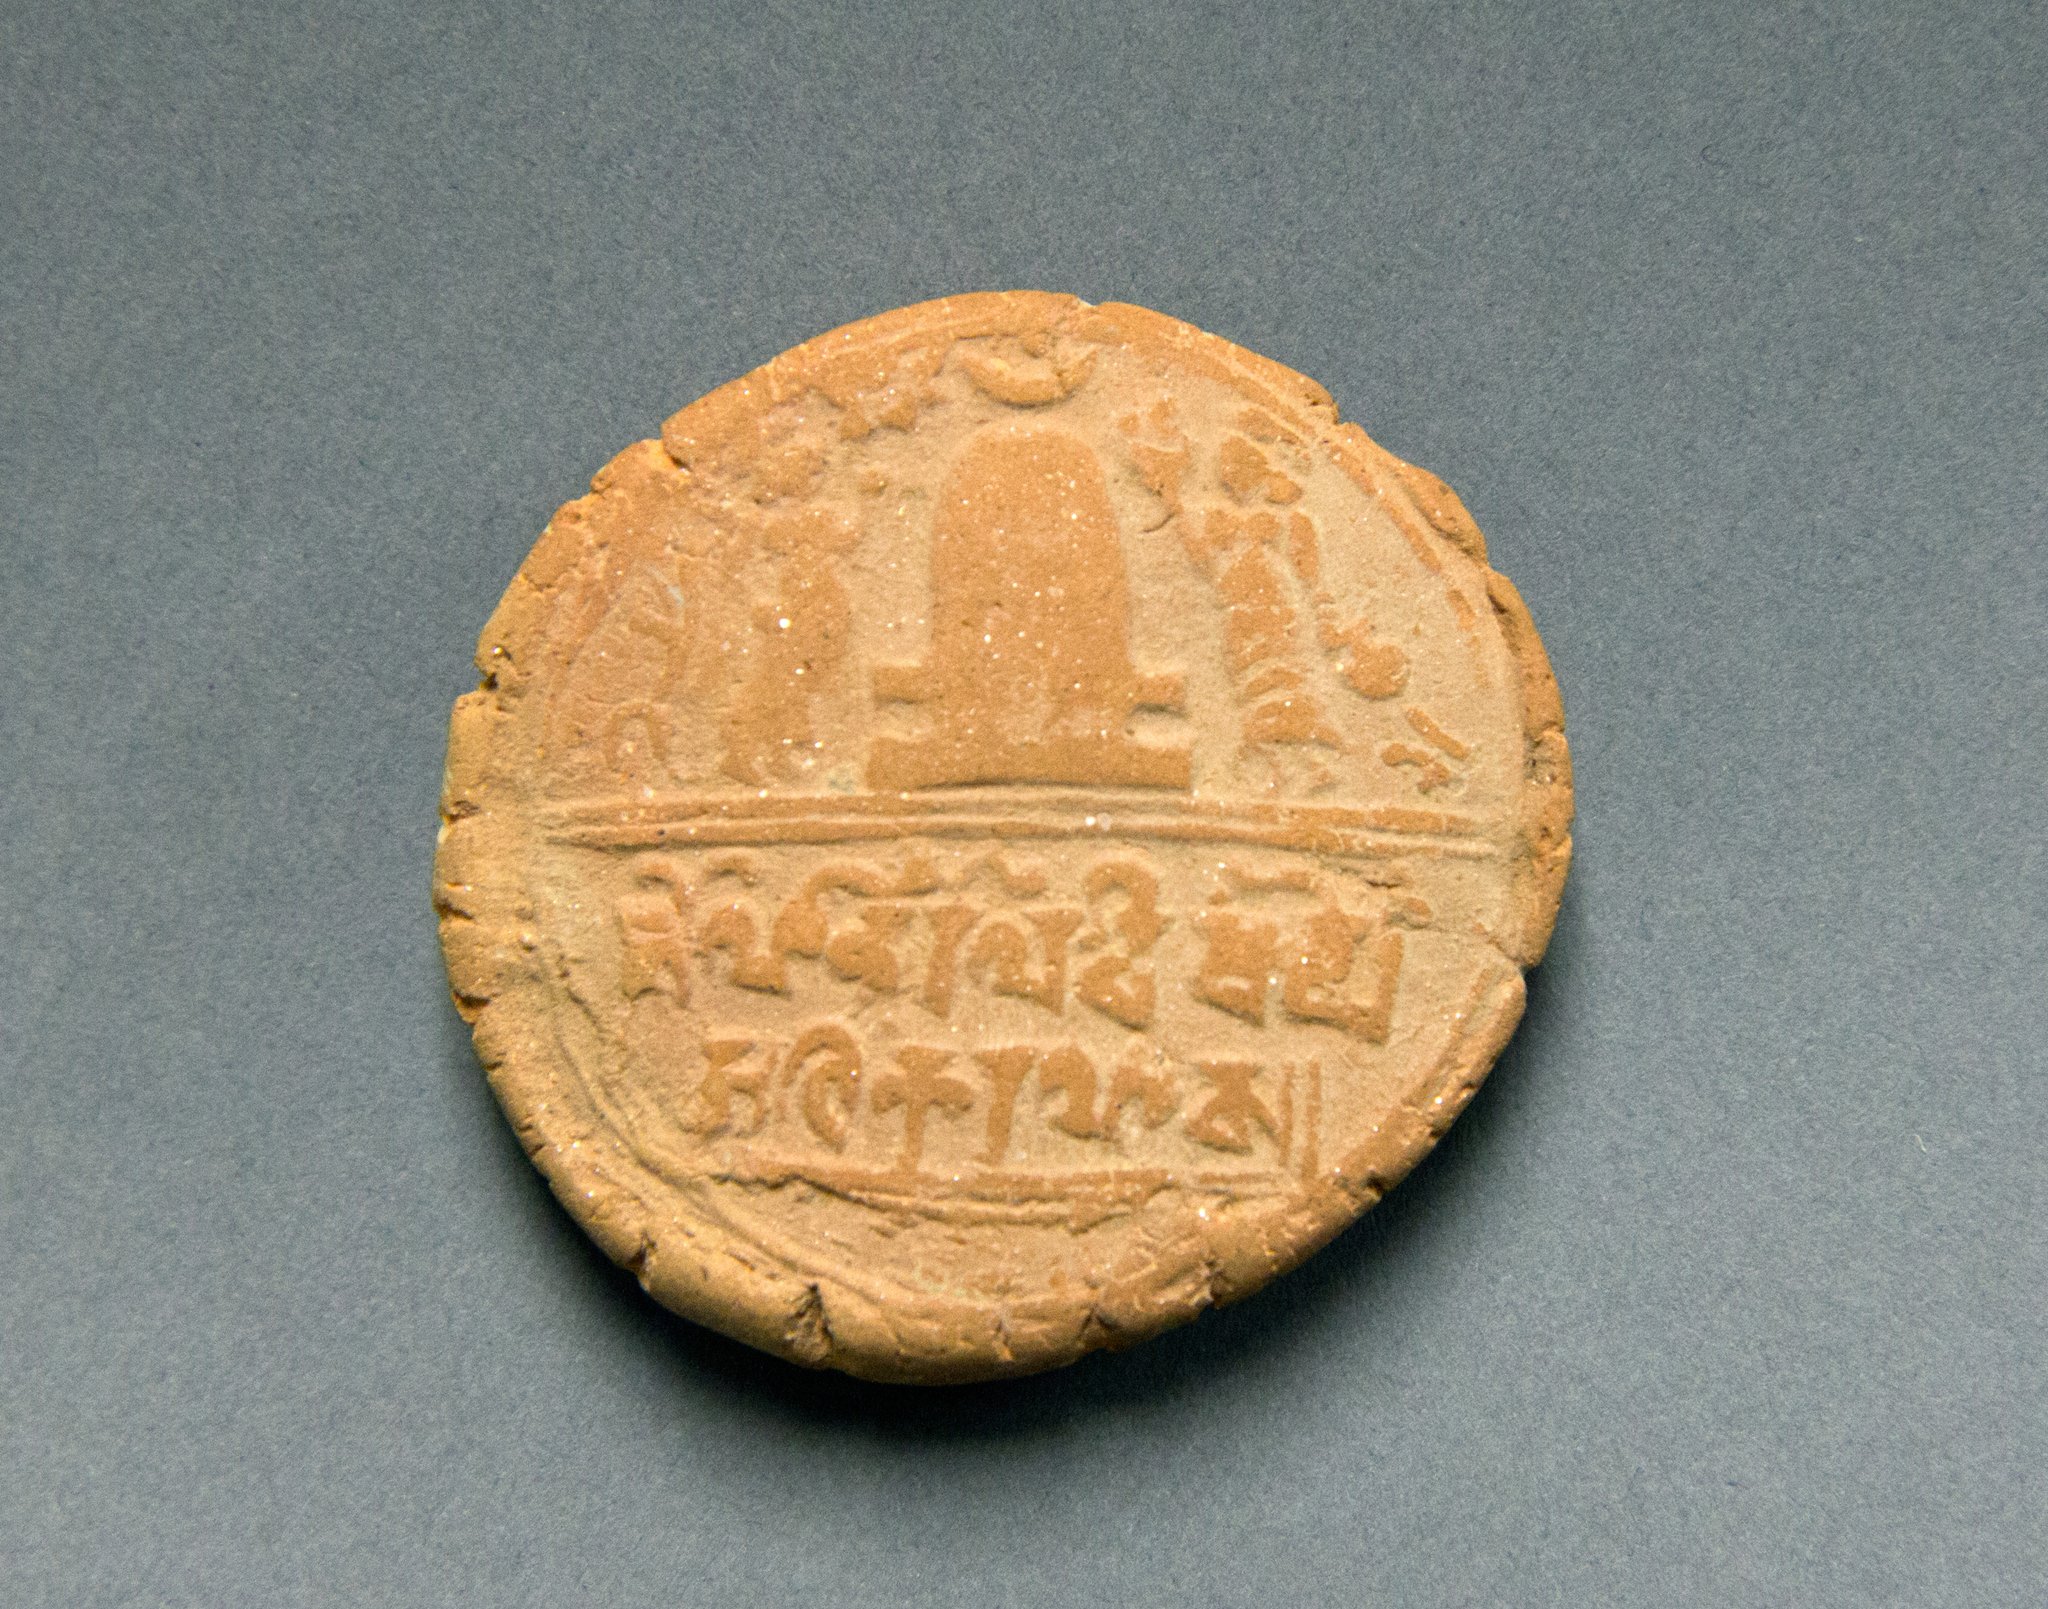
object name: seal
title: Round Seal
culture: indian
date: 401-500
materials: terracotta